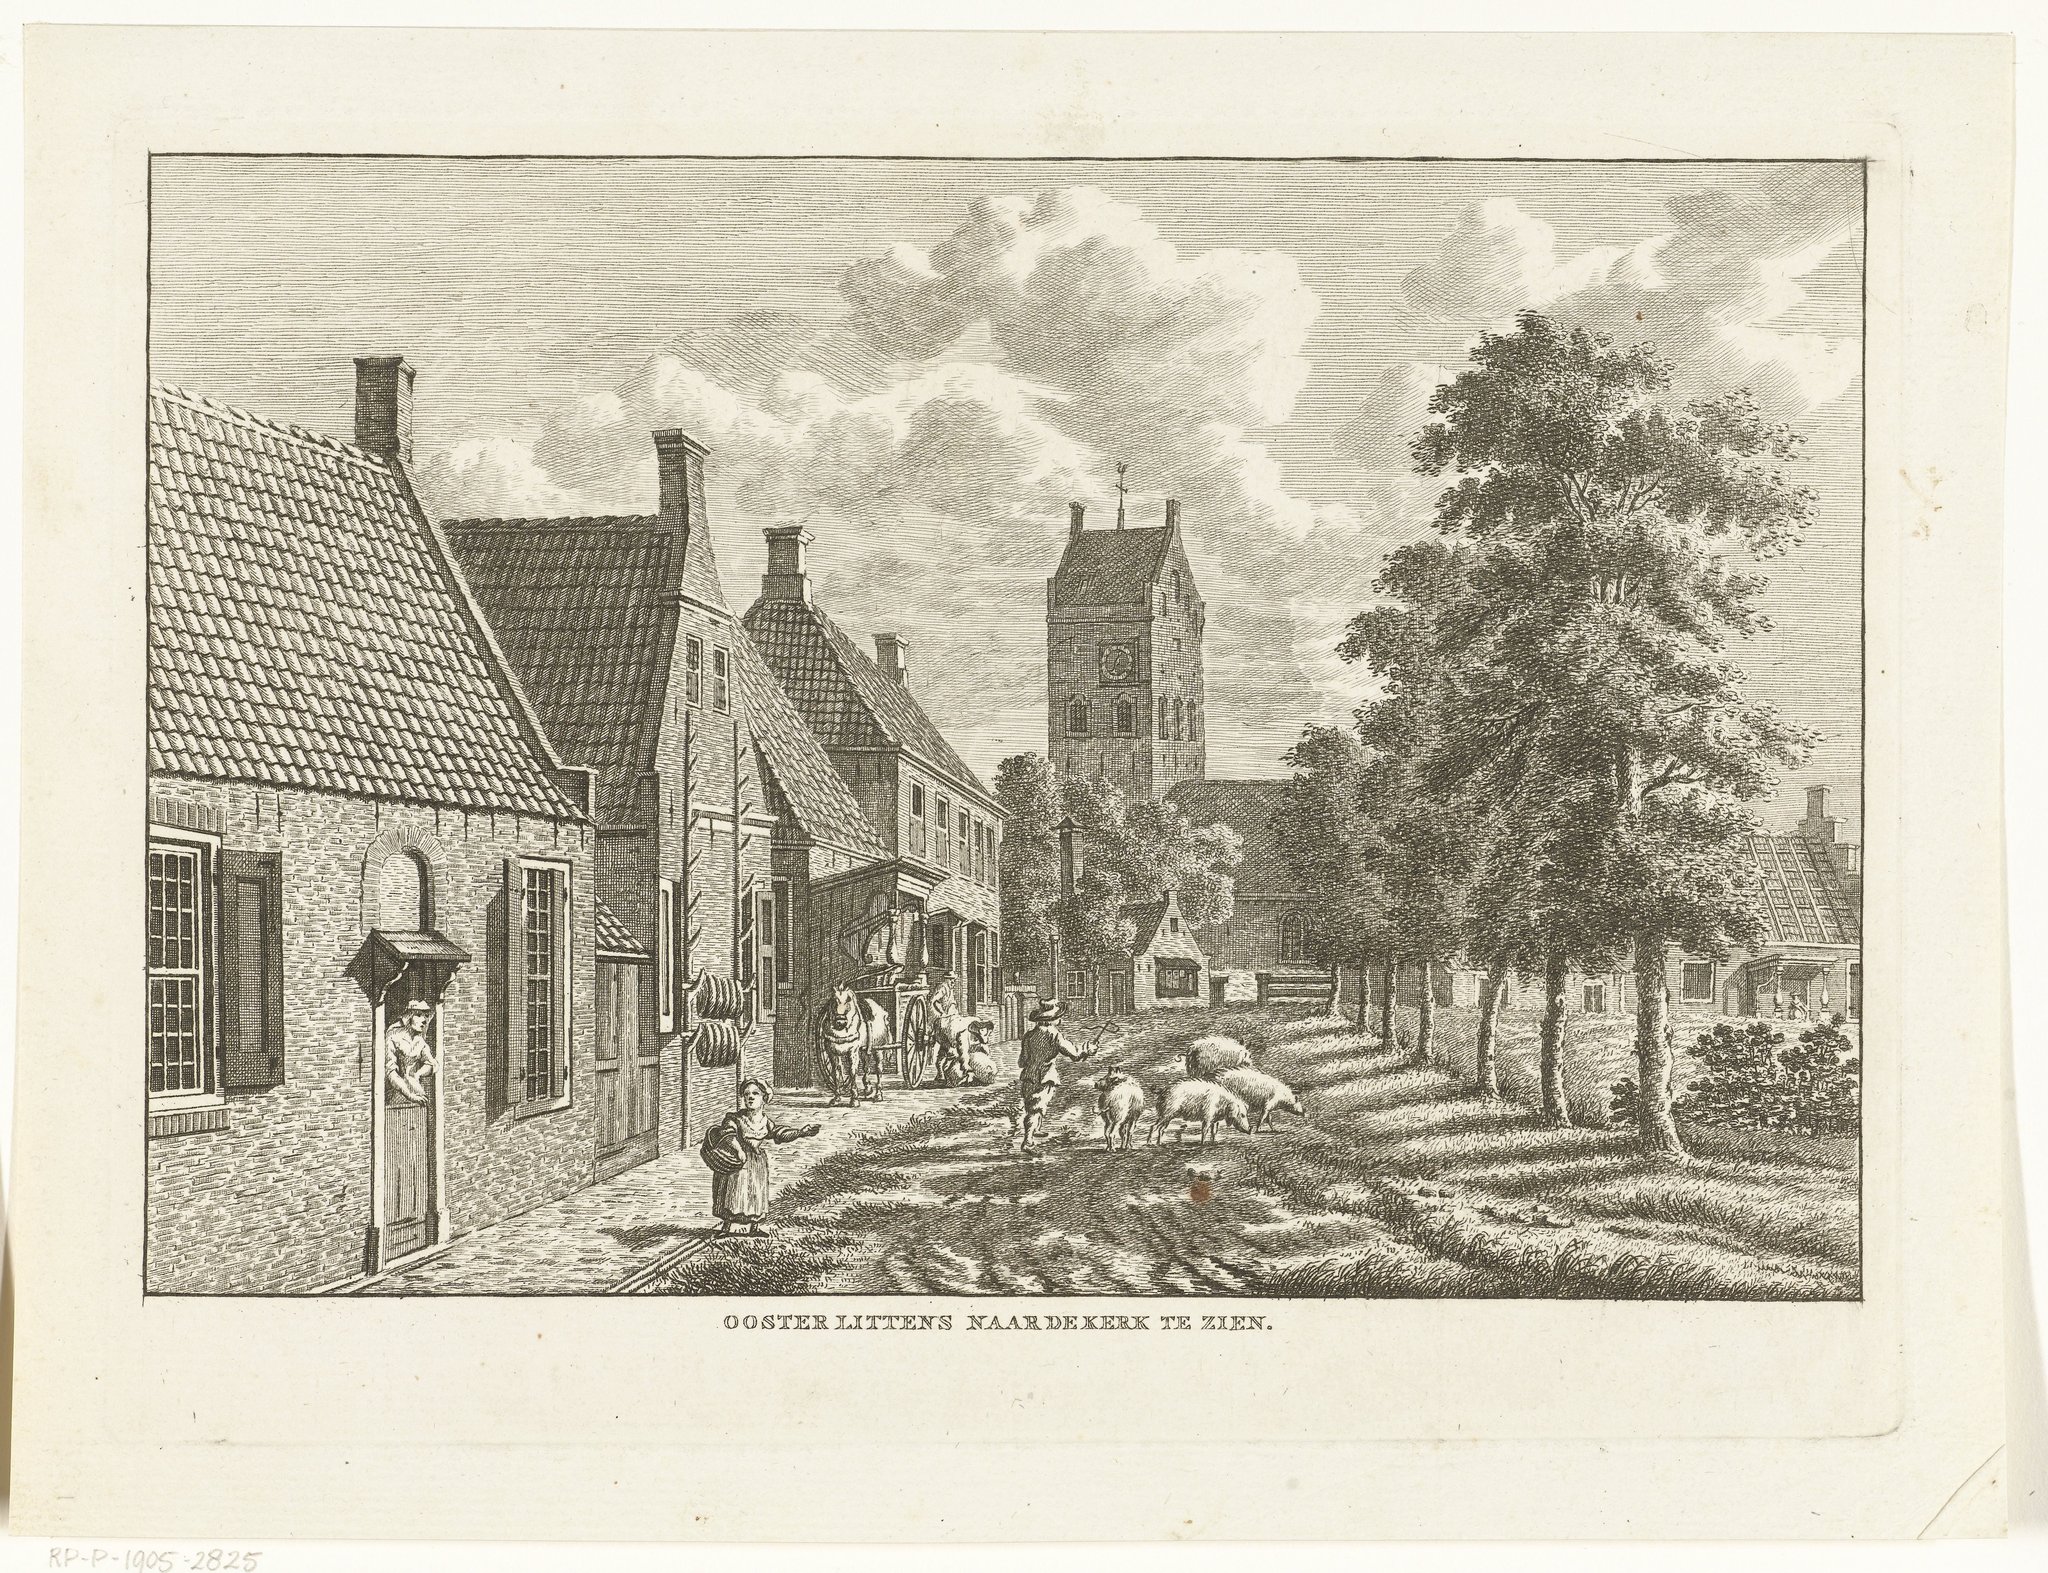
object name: print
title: Ooster Littens naar de kerk te zien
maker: carel frederik bendorp (i)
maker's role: print maker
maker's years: 1736-1814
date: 1786-1792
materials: paper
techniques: etching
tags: village, church (exterior)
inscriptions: collector's mark: Lugt 2228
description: Prent uit: Vaderlandsche gezichten, of afbeeldingen van den tegenwoordigen staat der Vereenigde Nederlanden (…). Amsterdam: Hendrik Gartman, Willem Vermandel en Jan Willem Smit, 1786-1792. Uitgegeven in afleveringen met ieder een eigen bifolium en inhoudsopgave. Alle prenten in deze publicatie zijn gegraveerd door Carel Frederik Bendorp (I) en, in de meeste gevallen, gebaseerd op tekeningen van Jan Bulthuis.